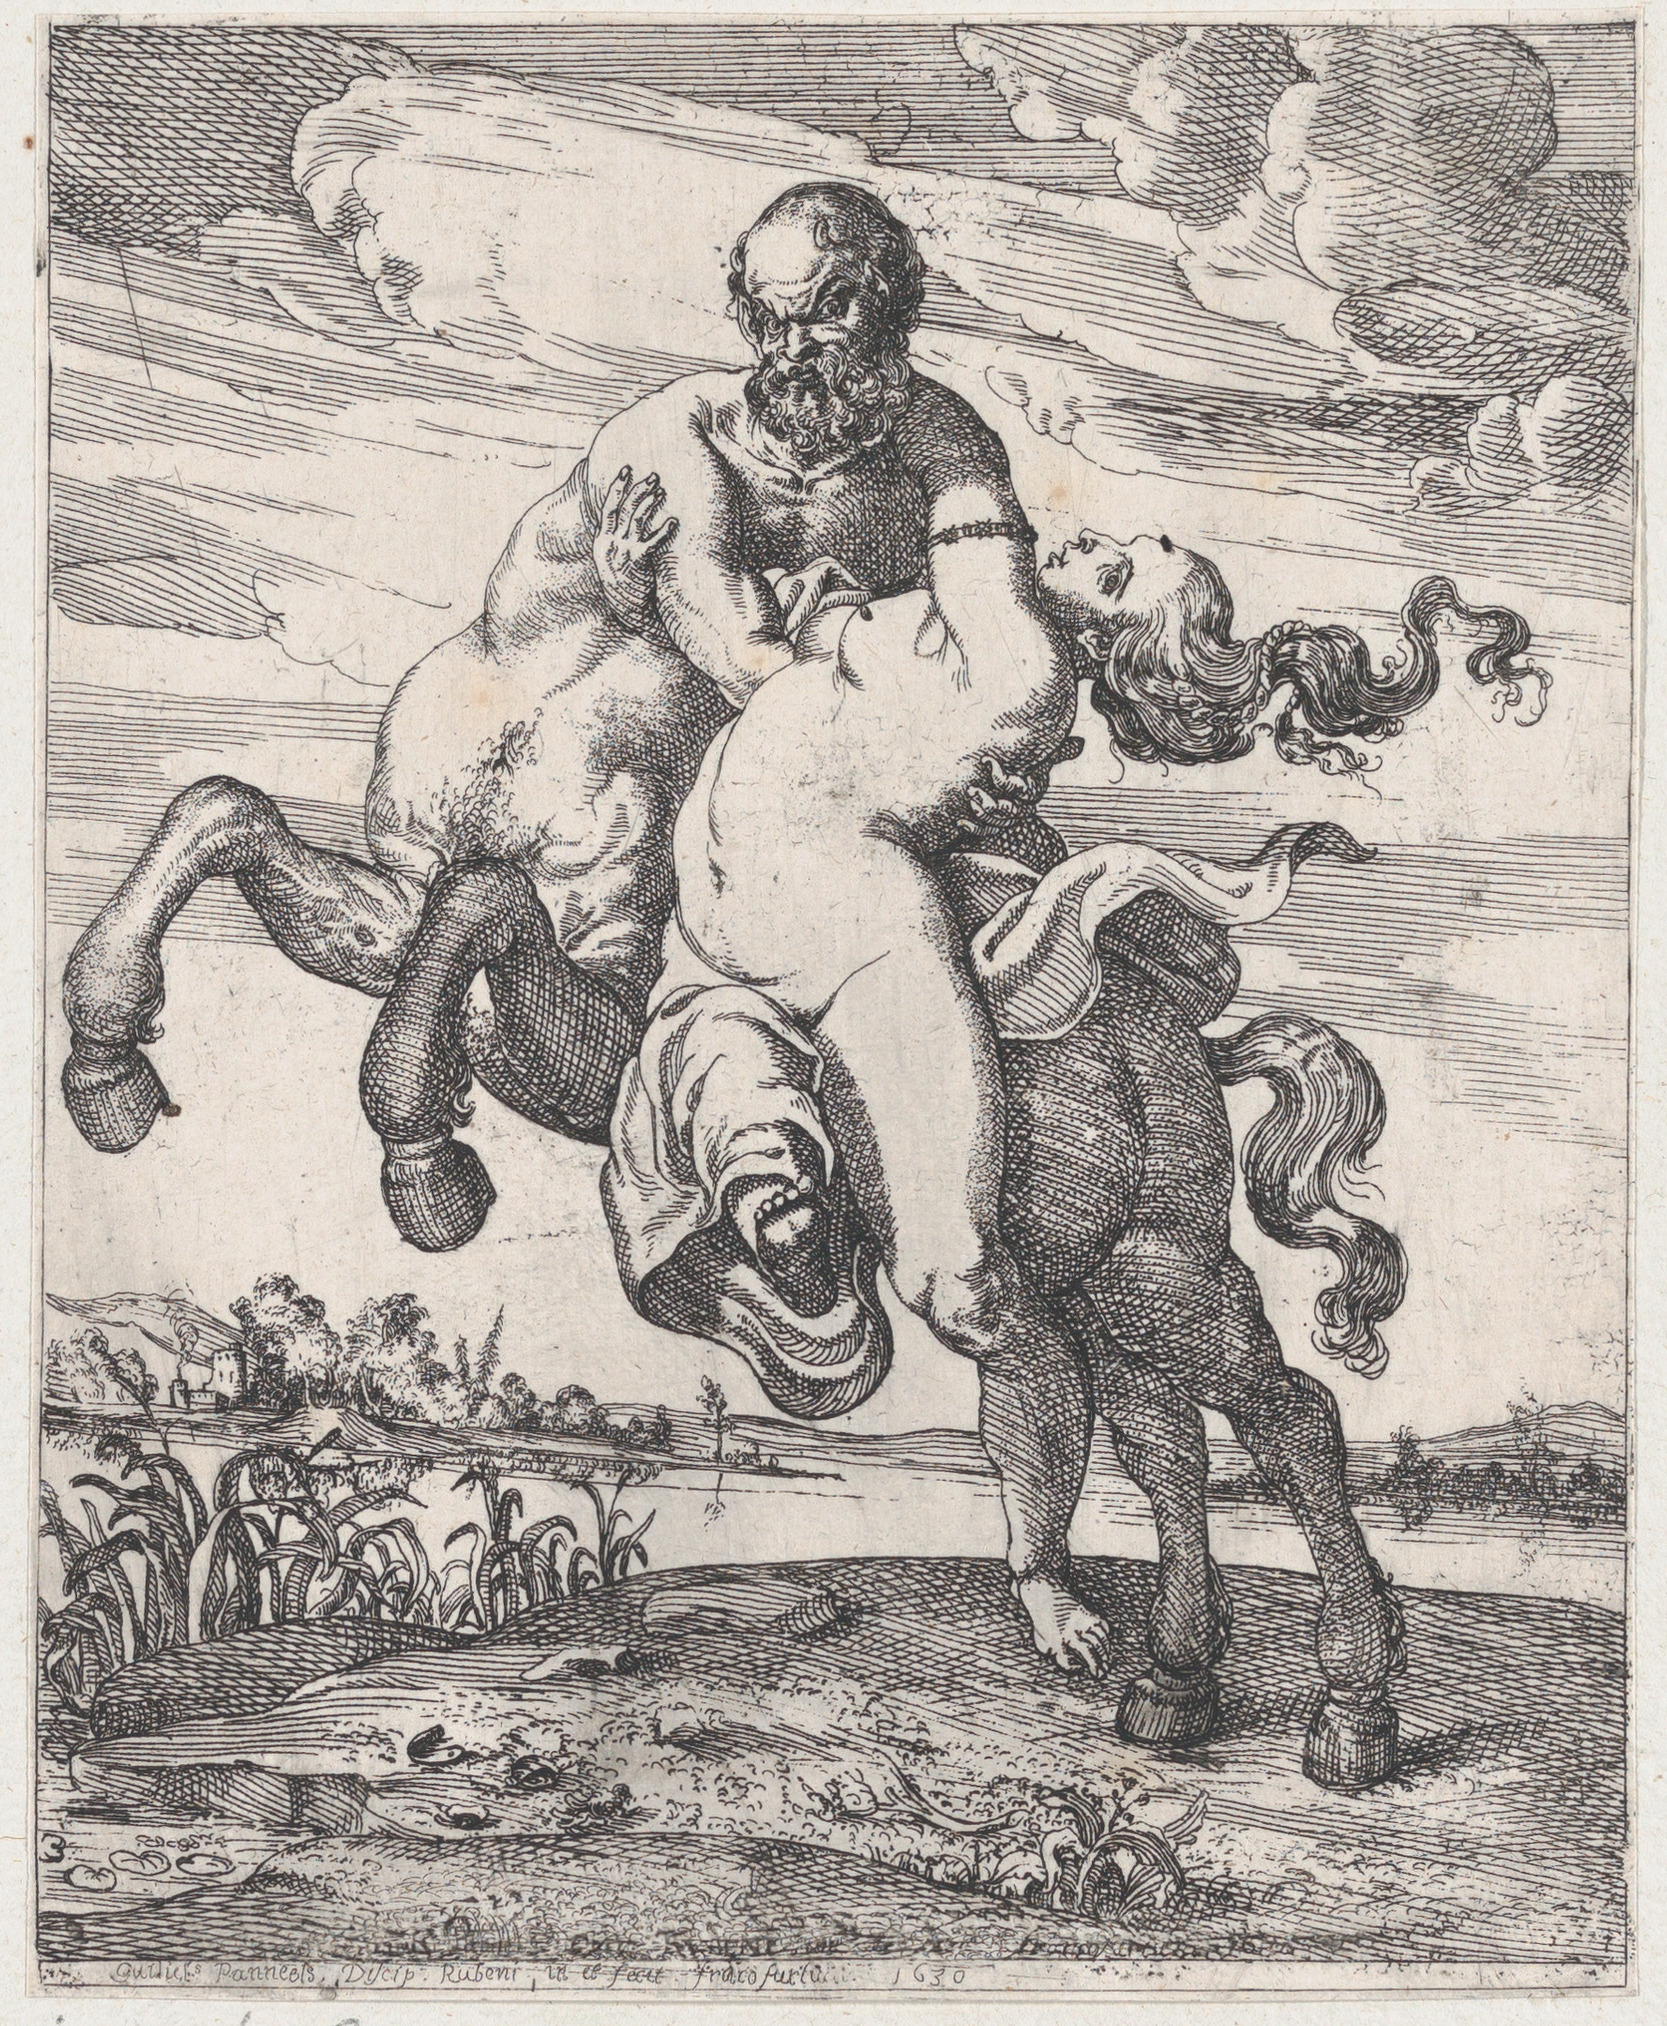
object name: print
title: Nessos abducting Deianira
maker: willem panneels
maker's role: artist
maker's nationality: flemish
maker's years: 1600-1632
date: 1630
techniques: etching